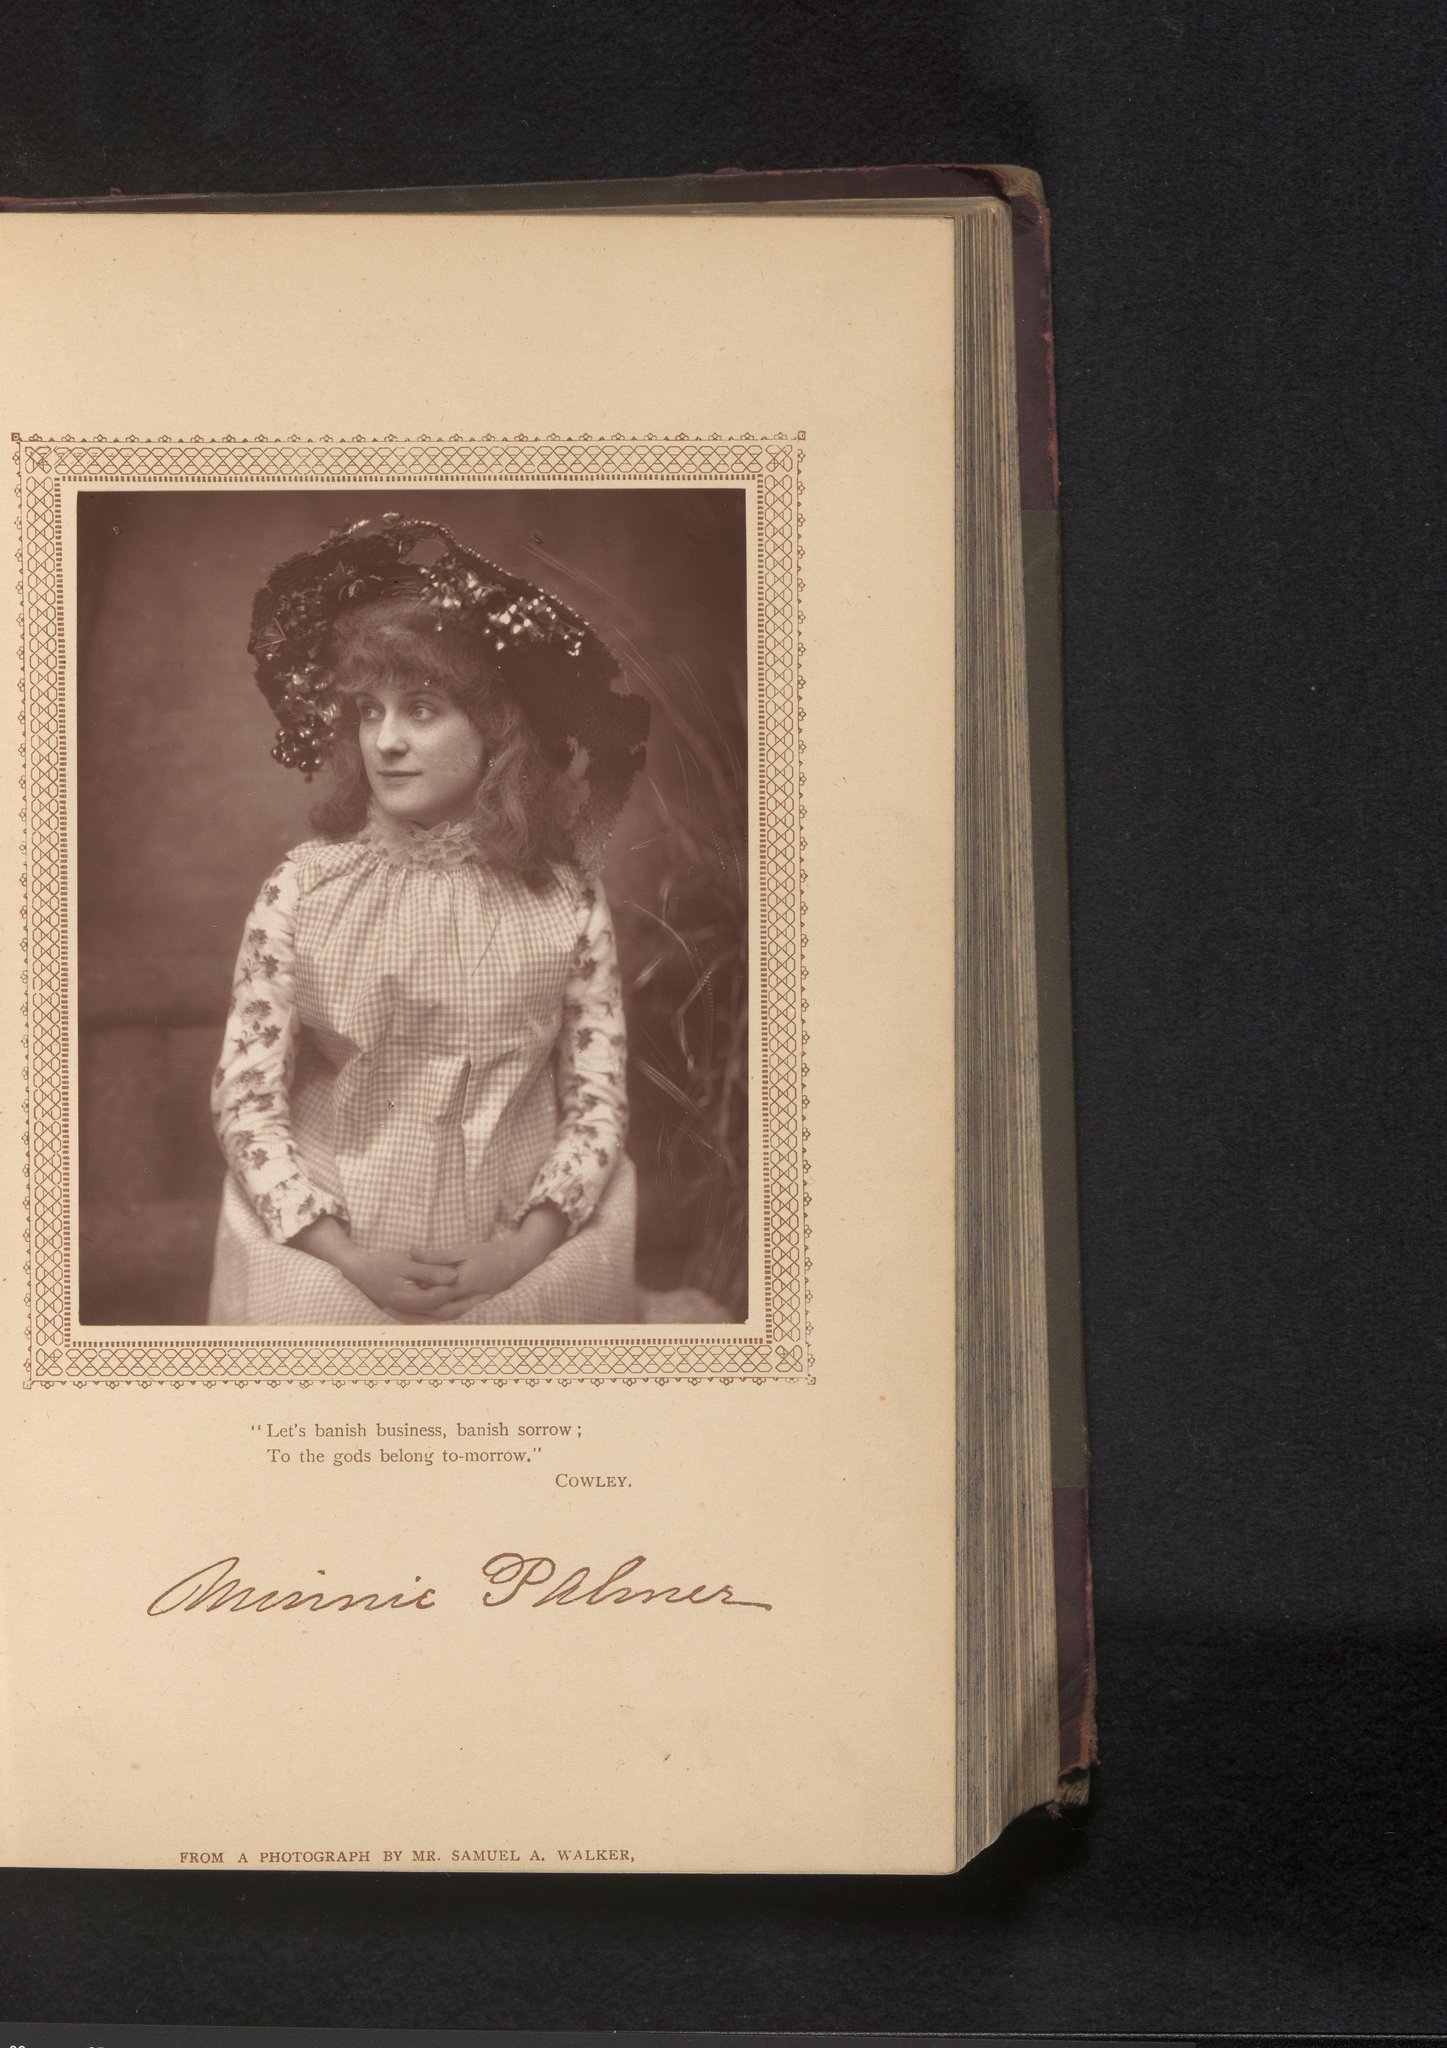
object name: page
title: Portret van Minnie Palmer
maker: Anonymous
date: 1879-1884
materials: paper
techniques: woodburytype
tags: adult woman, historical persons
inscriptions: signature: ‘Minnie Palmer’, inscription: ‘'Let's banish business banish sorrow;/ To the gods belong to-morrow.'/ - Cowley’